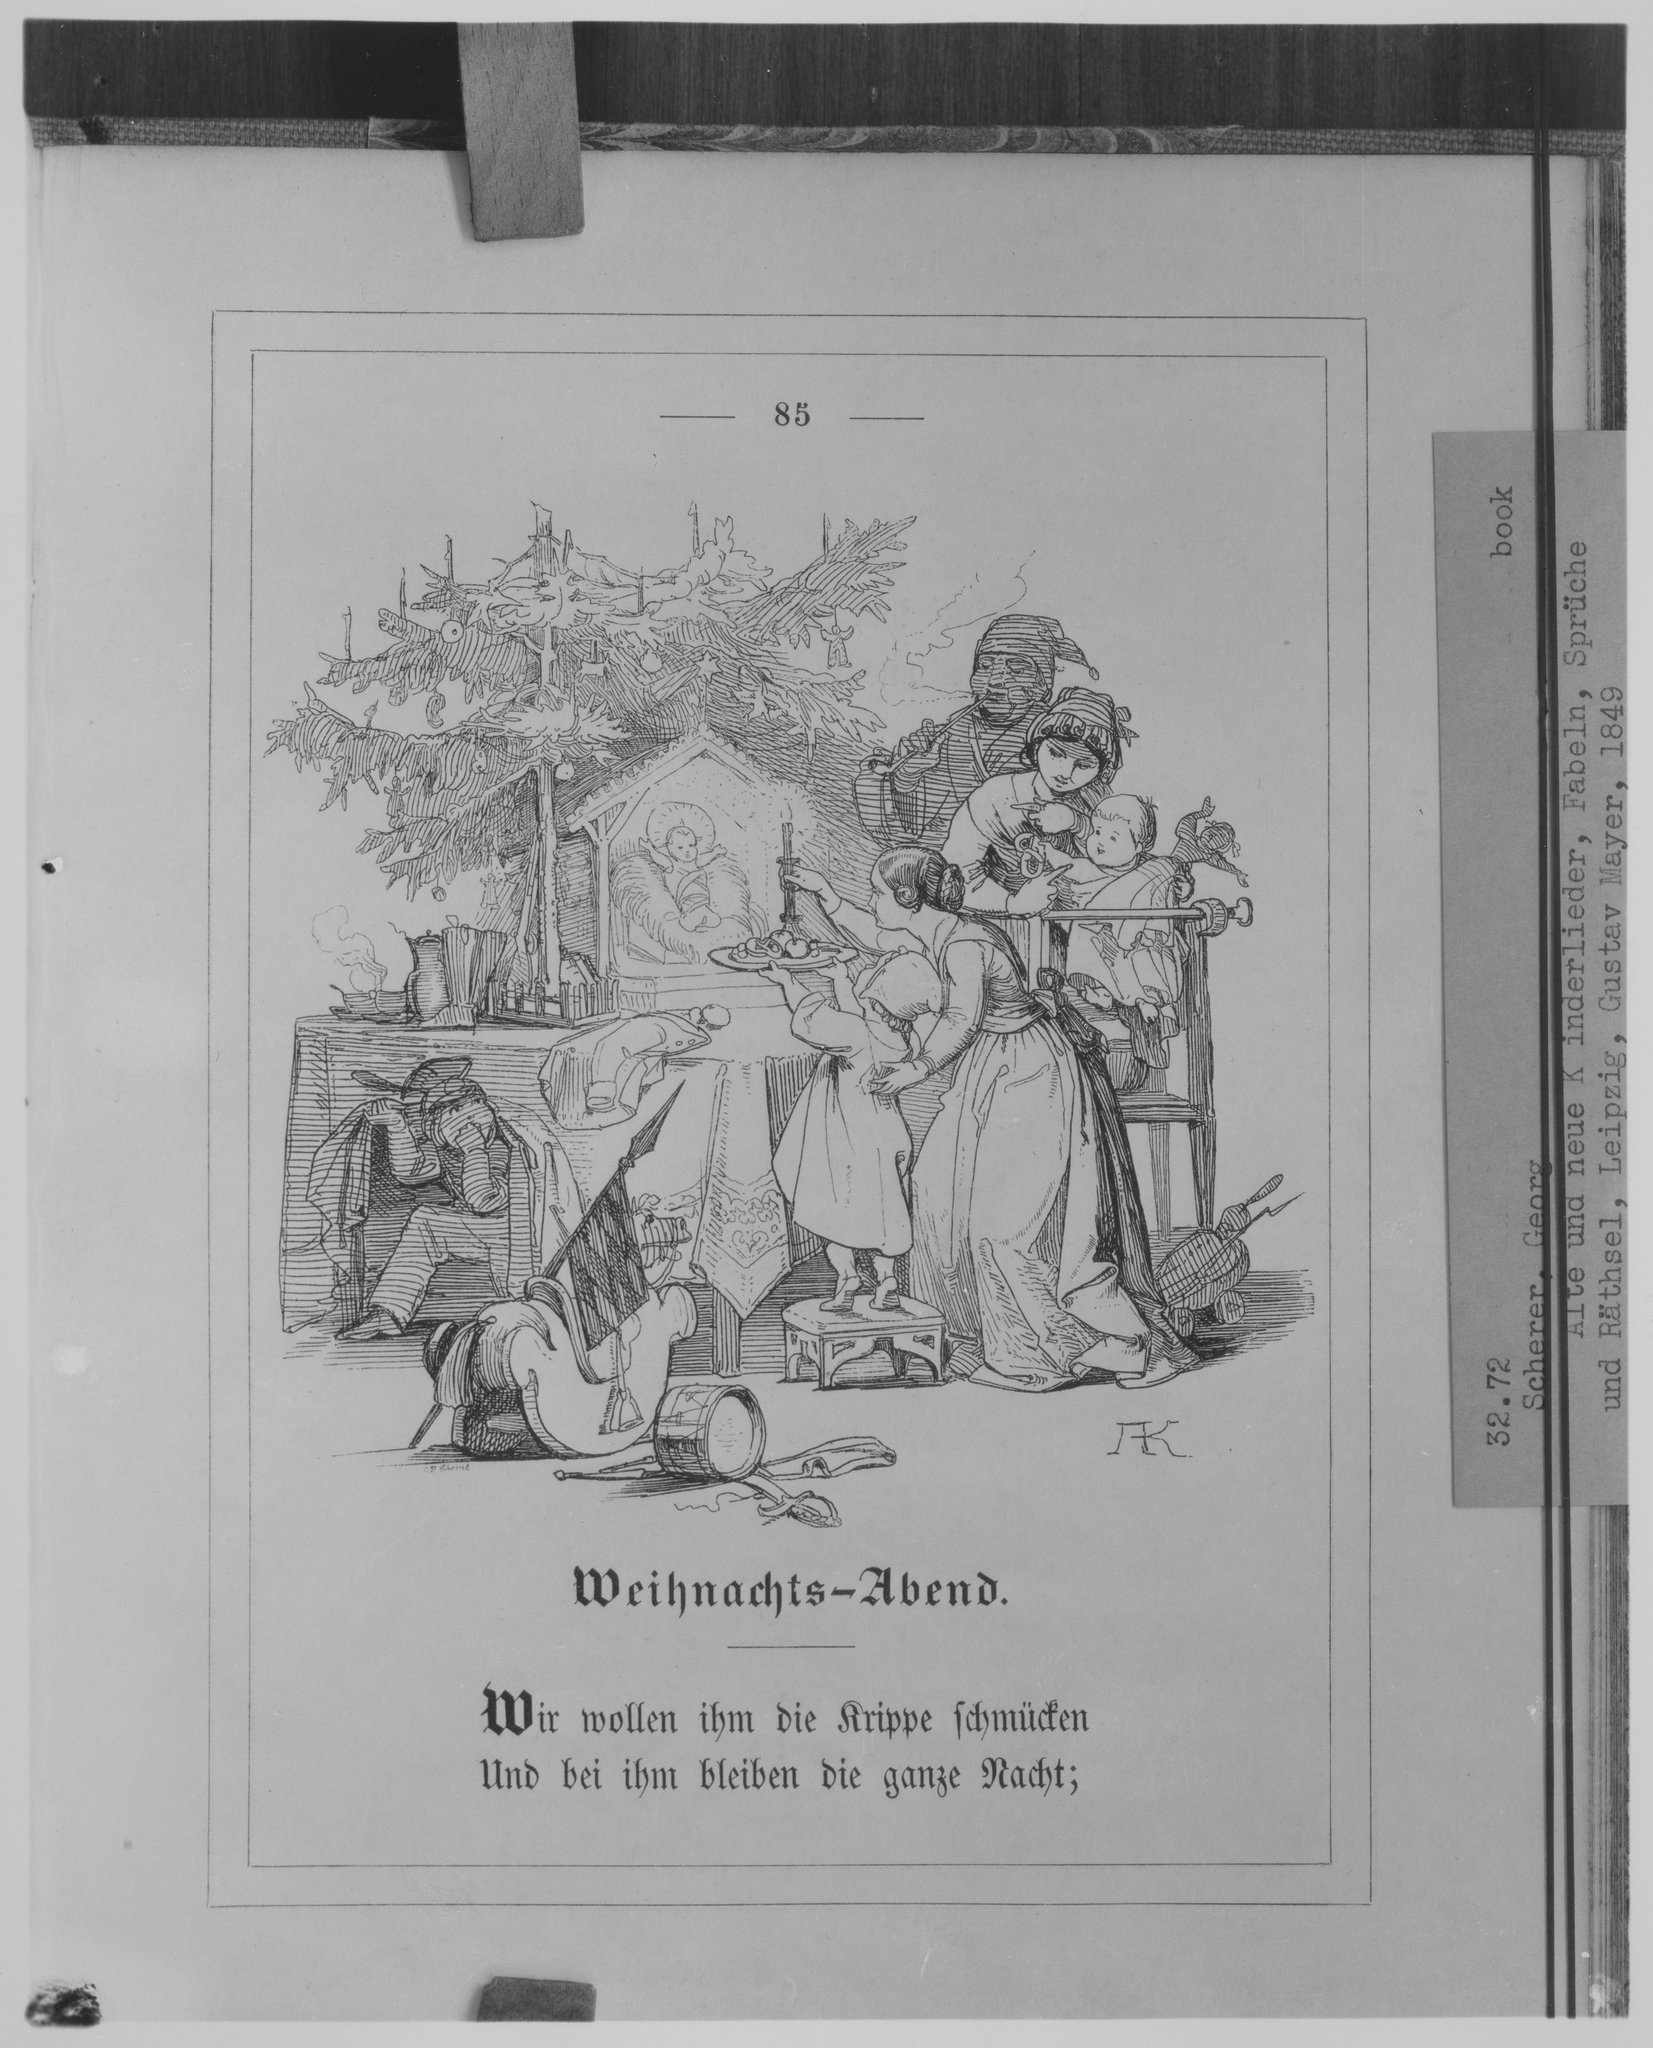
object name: book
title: Alte und neue Kinderlieder, Fabeln, Sprüche und Räthsel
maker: adrian ludwig richter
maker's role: artist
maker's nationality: german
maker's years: 1803-1884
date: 1849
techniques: etching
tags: children,men,women